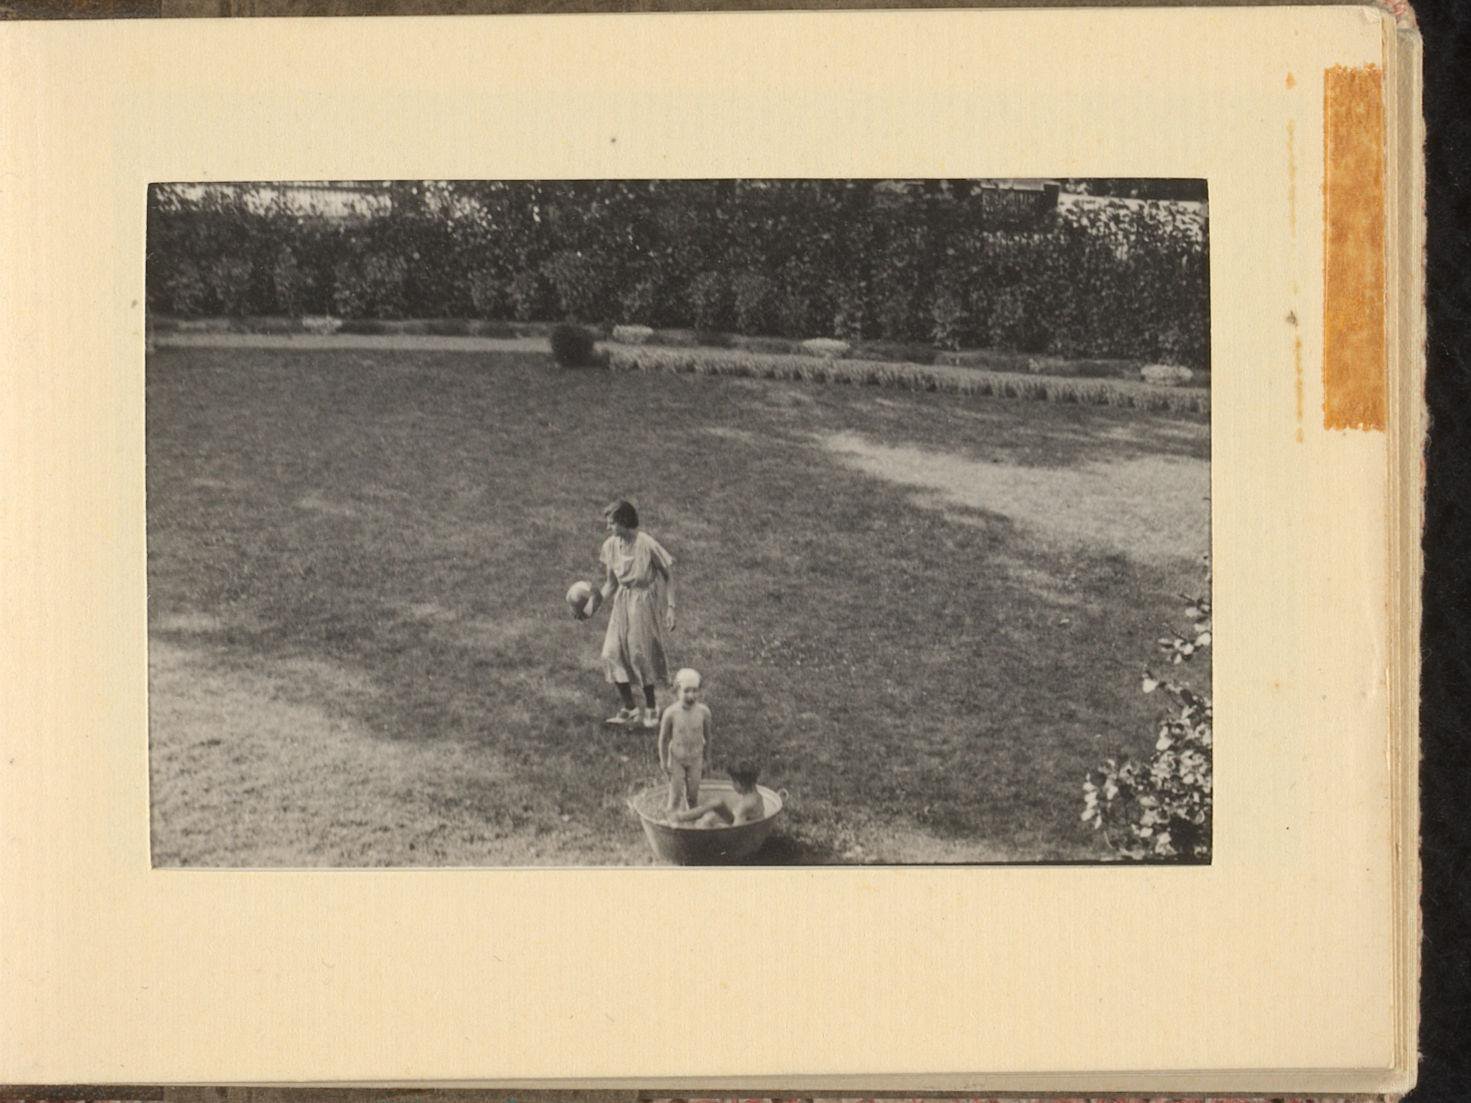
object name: photograph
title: Isabel Wachenheimer in de tobbe met een onbekend jongetje en het kindermeisje, juli-augustus 1933, Hamburg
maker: else wachenheimer-moos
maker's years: 1895-1944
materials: paper, photographic support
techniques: gelatin silver print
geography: hamburg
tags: leiden, isabel wachenheimer-elon, the family travelling, on holiday, children's games and plays, tub-bath - aa - in the open air, bathing baby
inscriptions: date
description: Albumblad bevat een foto van het kindermeisje (met bal), Isabel Wachenheimer (staand in tobbe) en onbekend jongetje (zittend in tobbe). Onderdeel van het fotoalbum Hamburg zomer 1933.